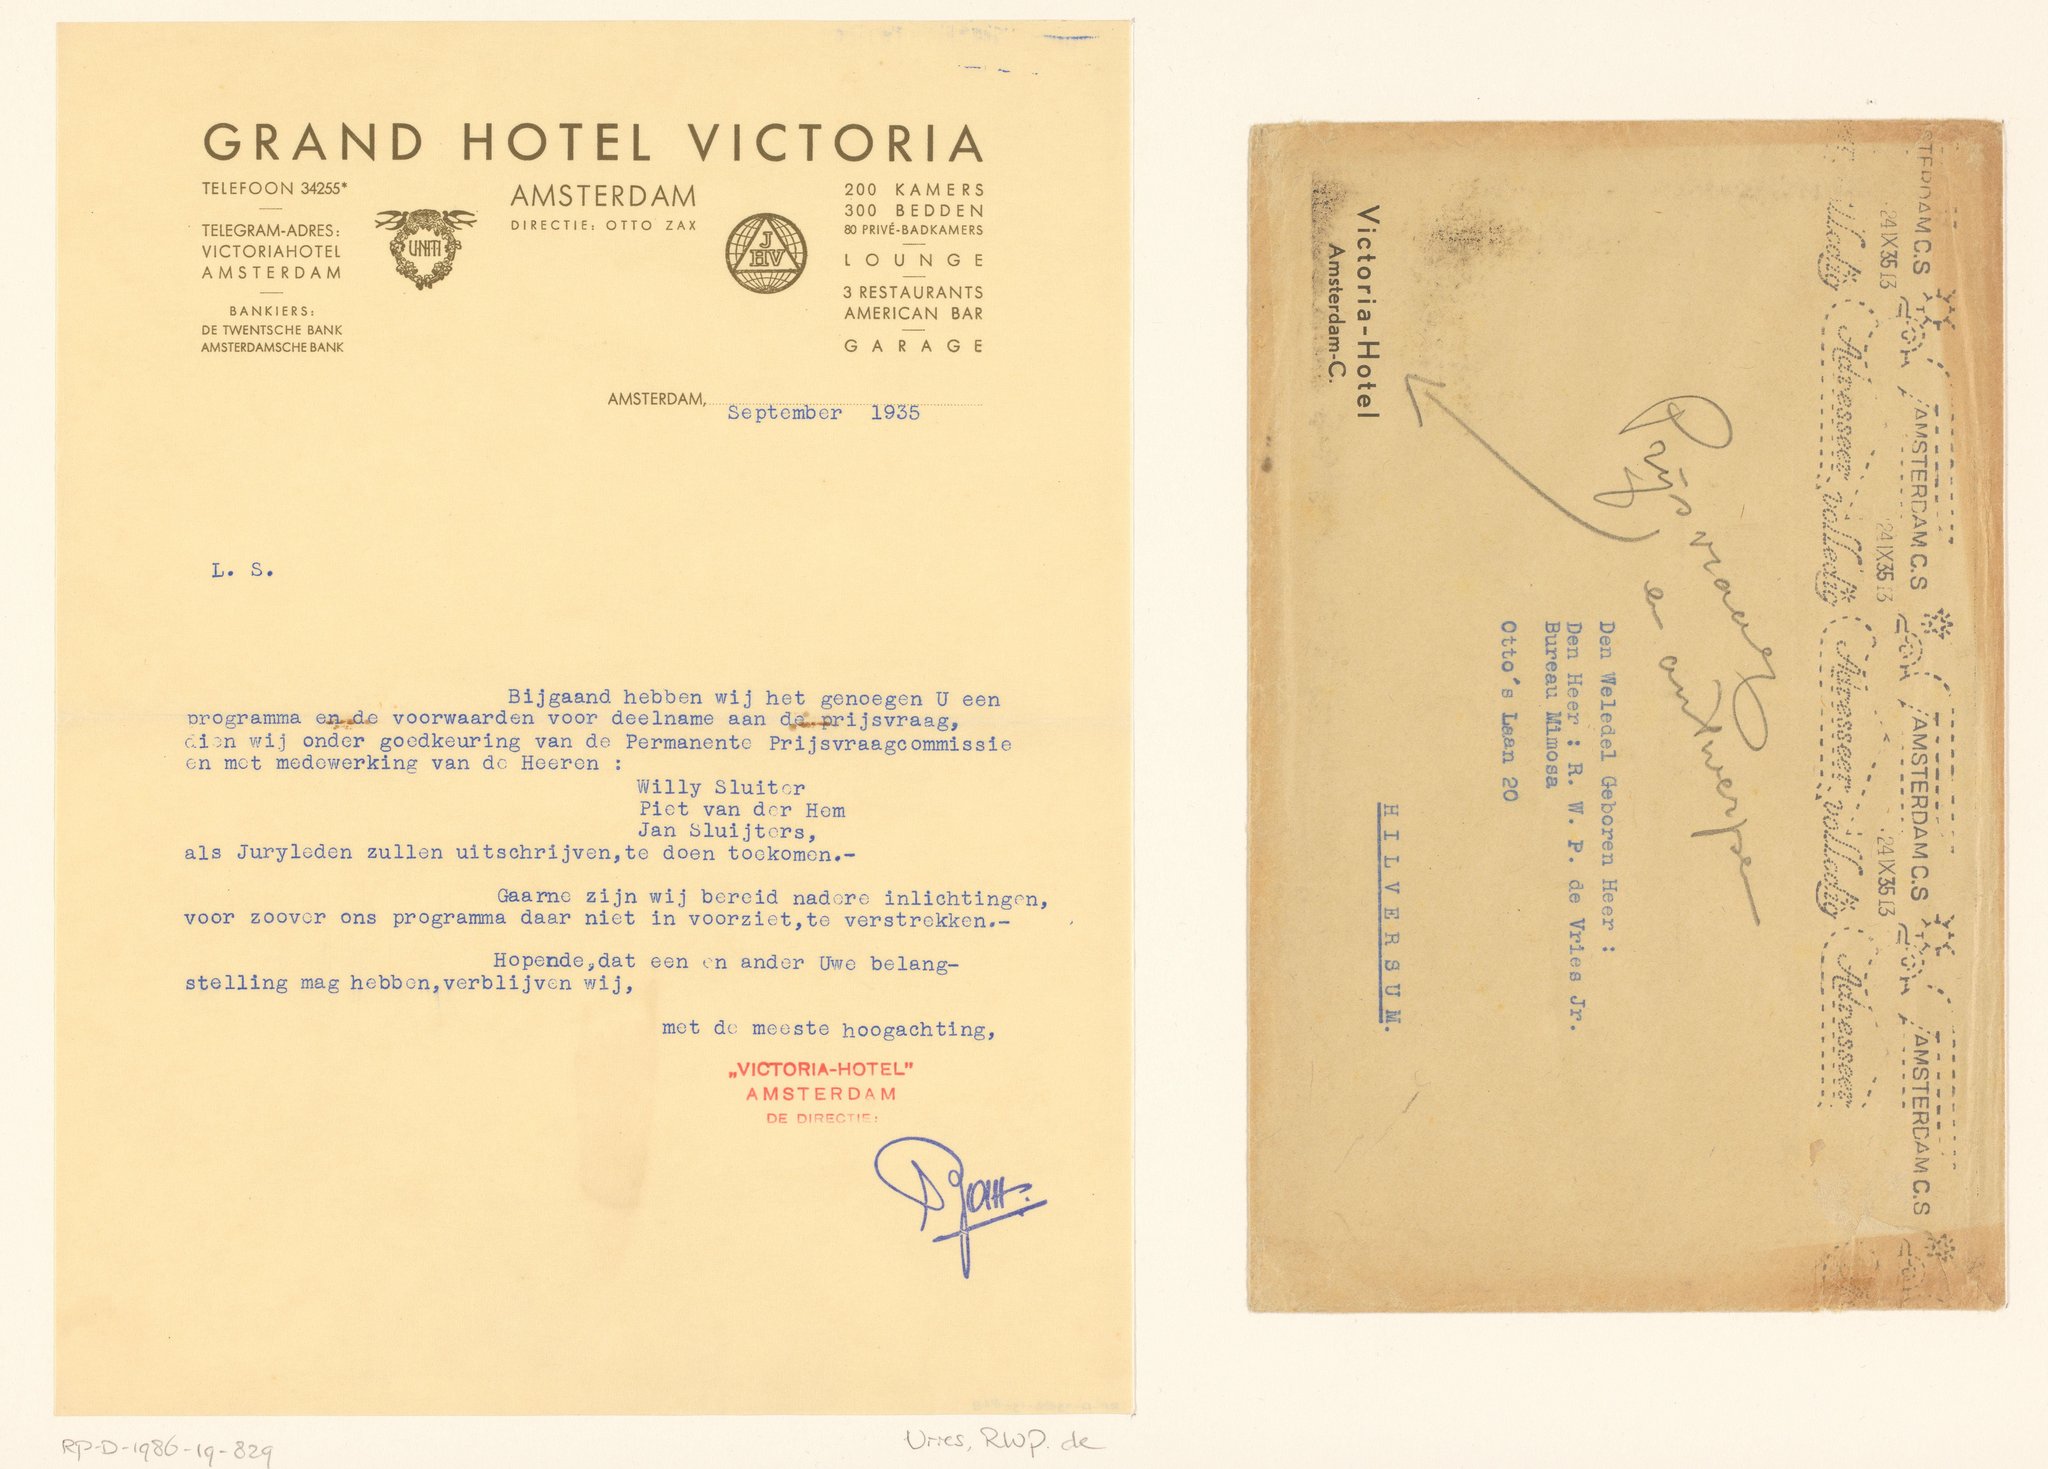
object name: letter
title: Brief aan R.W.P. de Vries Jr.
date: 1909-1935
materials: paper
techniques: printing, typewriting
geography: amsterdam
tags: amsterdam, print maker, draughtsman, reinier willem petrus de vries (1874-1953), the graphic arts, hotel, hostelry, inn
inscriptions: date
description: De brief heeft betrekking op de prijsvraag die het Victoria Hotel had uitgeschreven voor het ontwerp van een briefhoofd. Met de brief zijn meegezonden: tweemaal het programma en de voorwaarden van de prijsvraag, een folder van het hotel en het restaurant, een tarievenlijst en een afbeelding van het hotel.